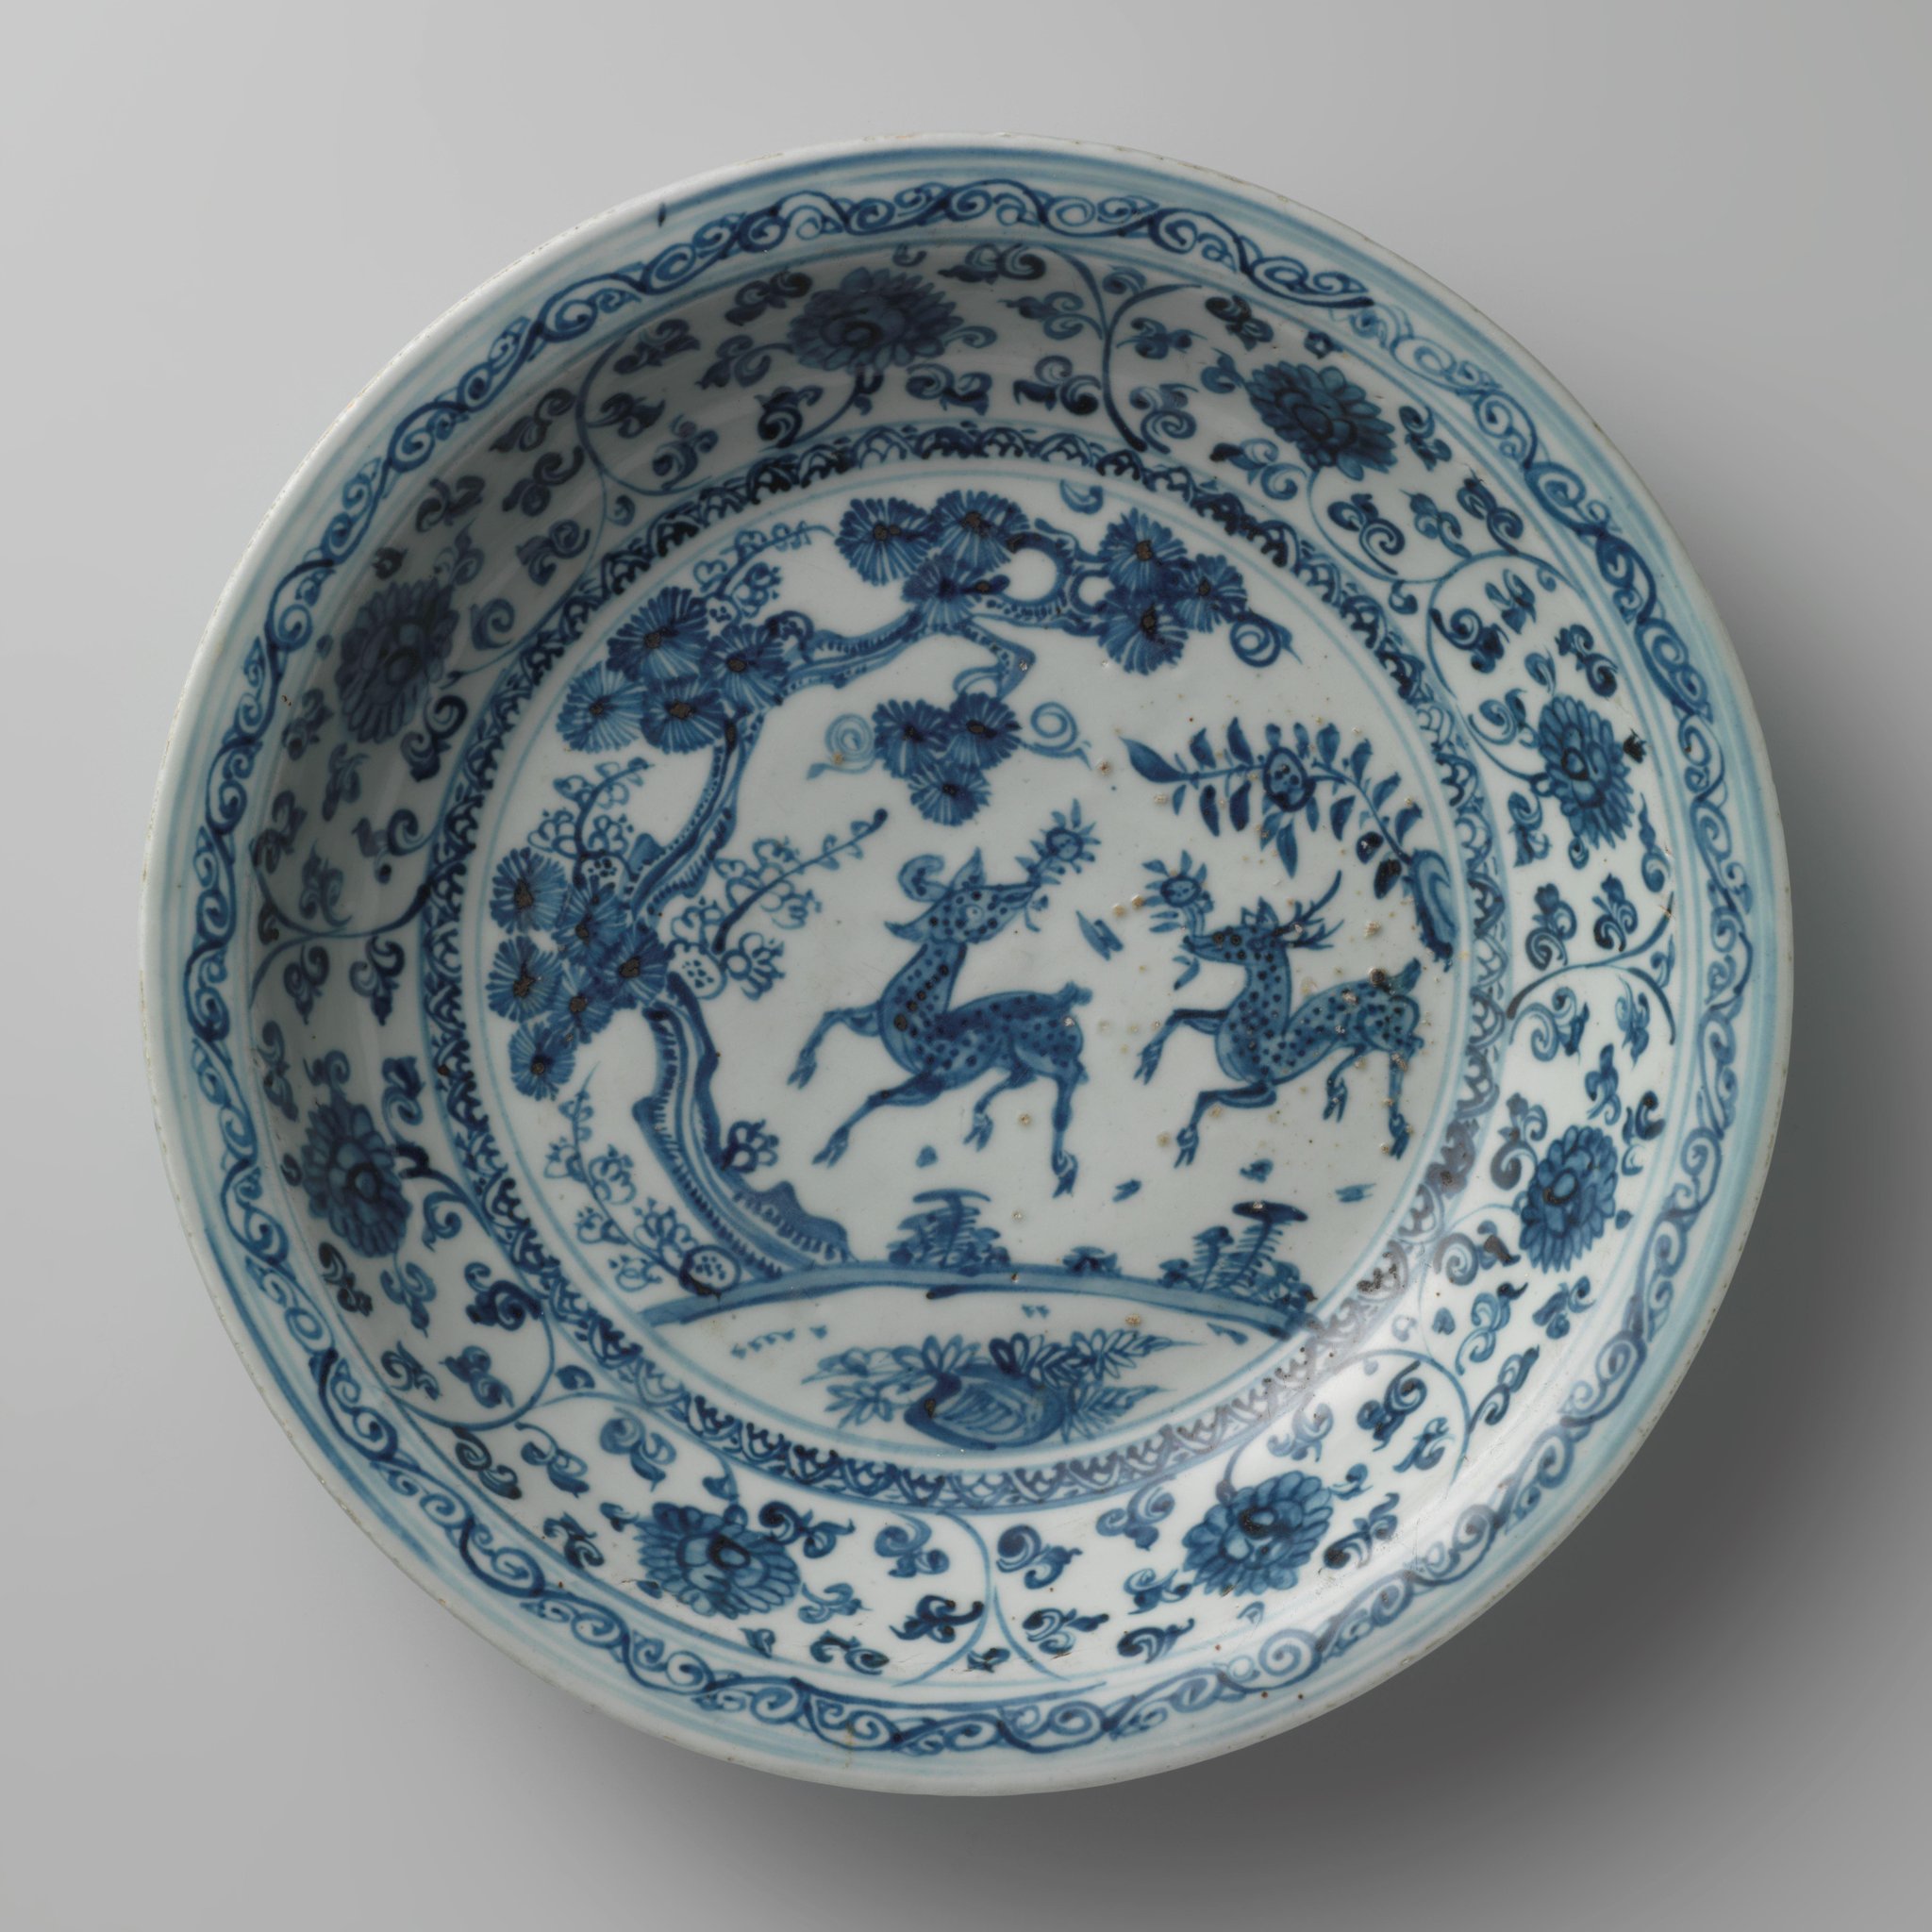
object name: platter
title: Dish with two deer in a landscape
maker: Anonymous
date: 1500-1524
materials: cobalt, glaze, paint, porcelain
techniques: firing, turning, vitrification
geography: china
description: Schaal, onderglazuurblauw, op de spiegel een tafereel met dansende herten.